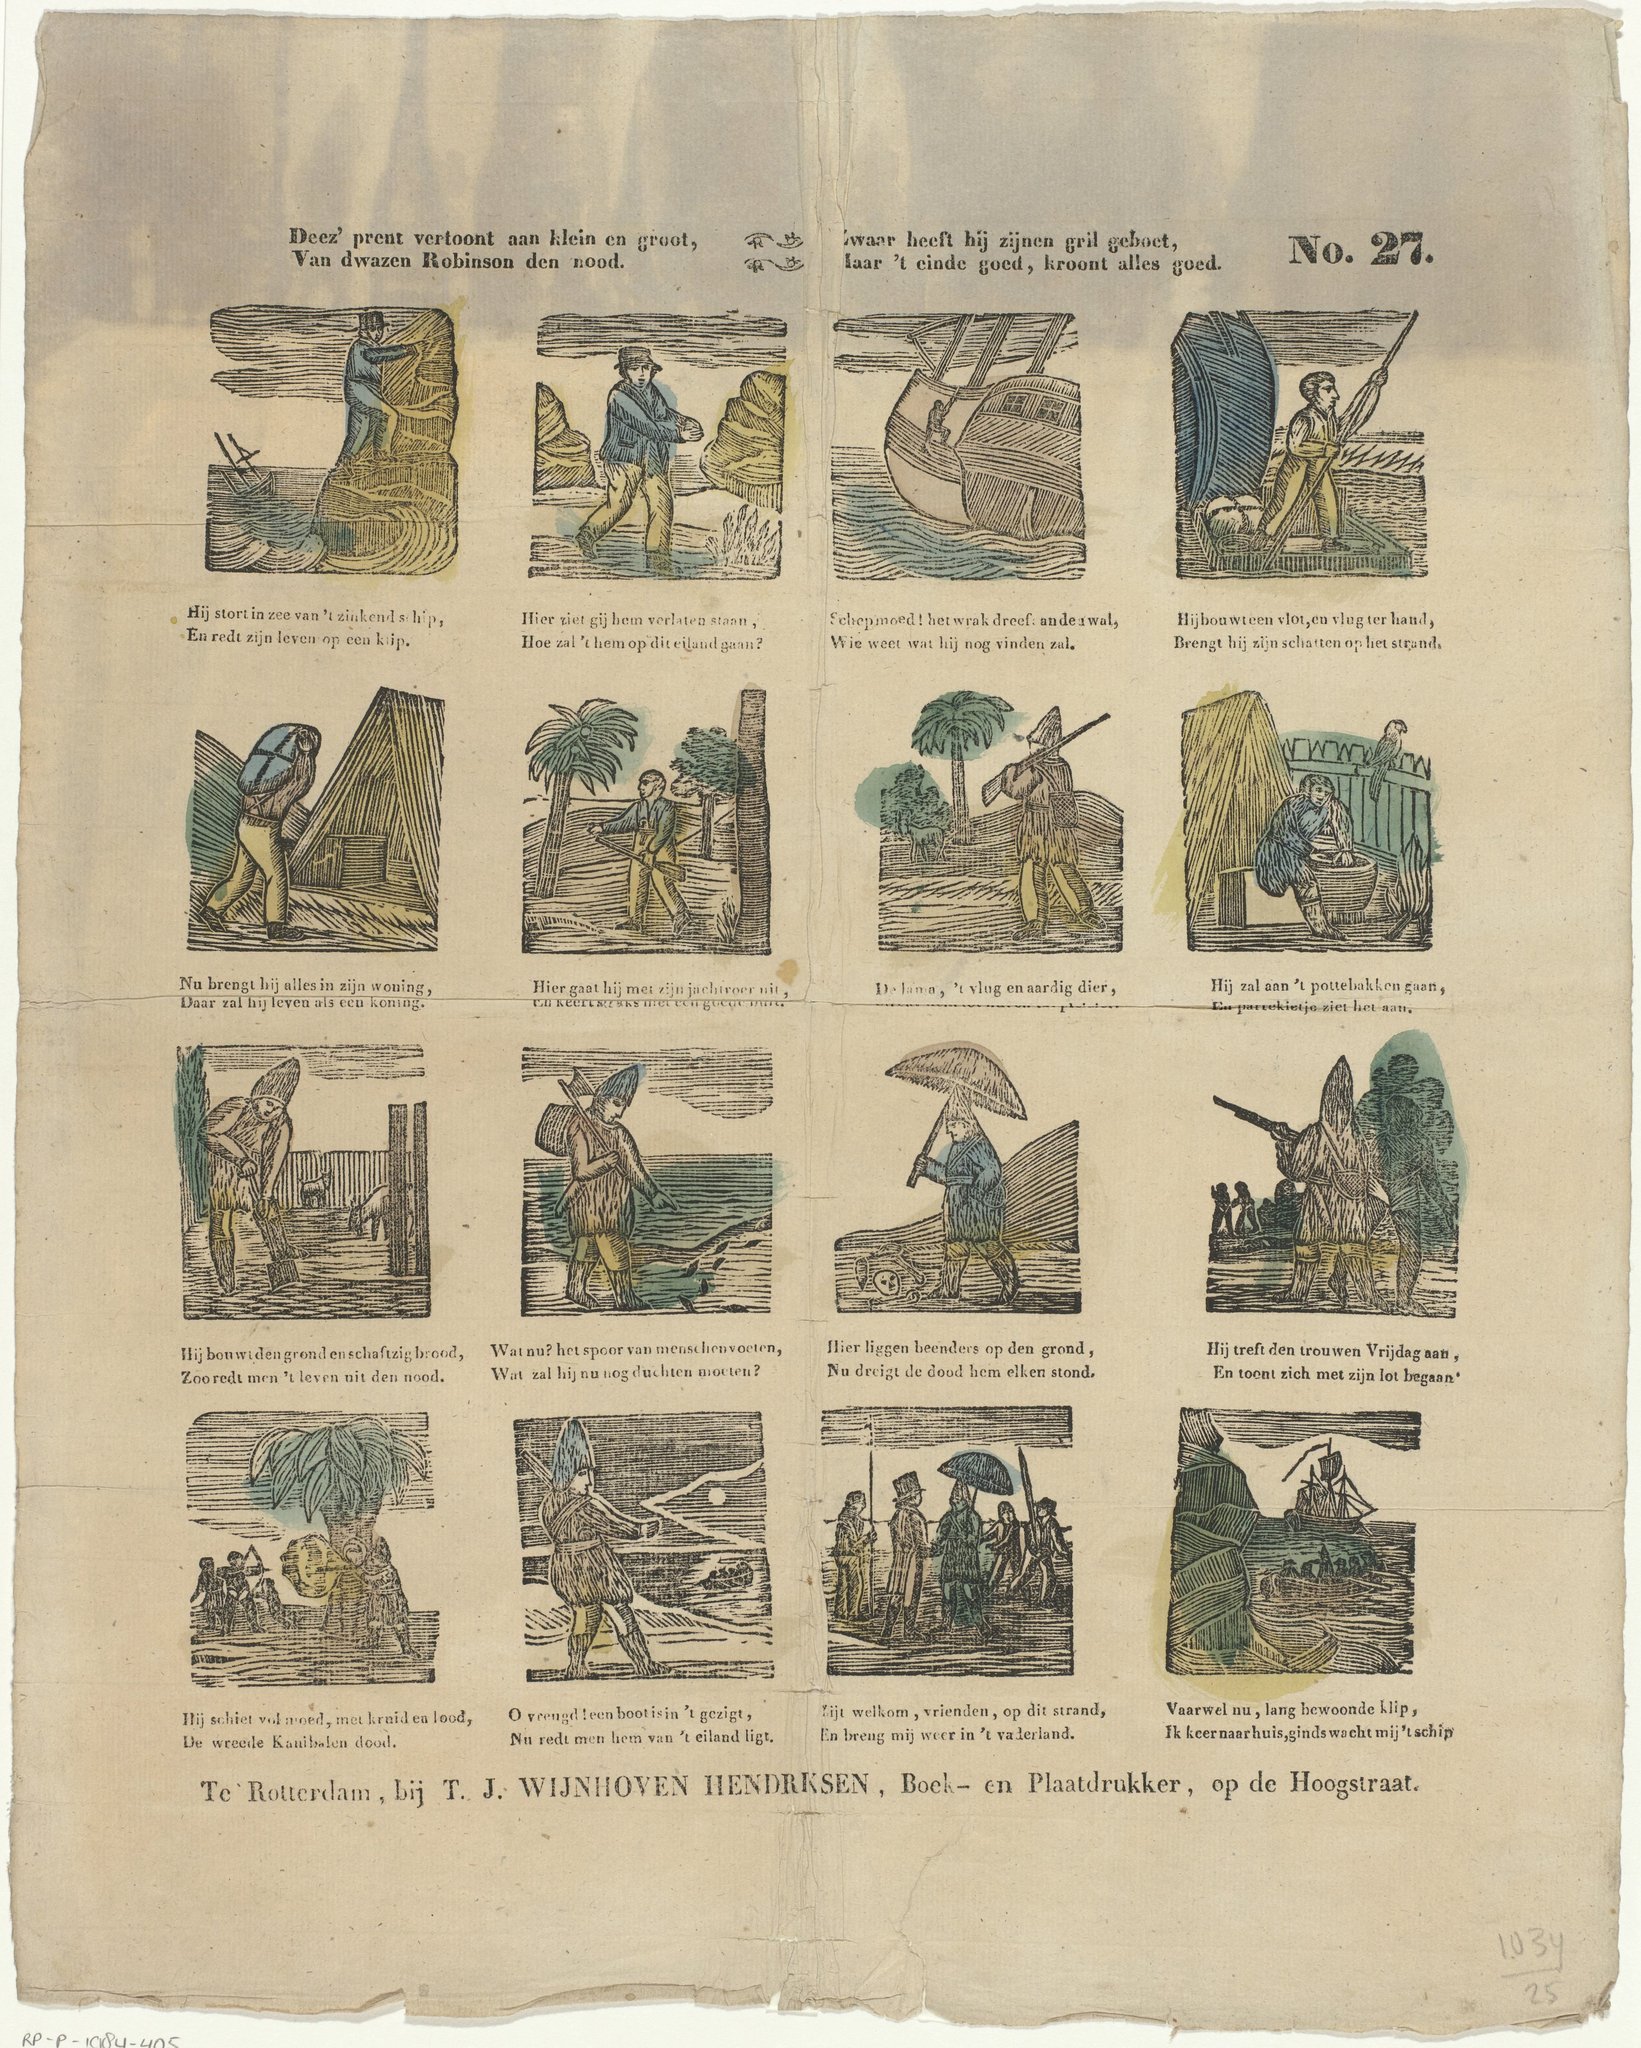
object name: print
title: Deez' prent vertoont aan klein en groot, / Van dwazen Robinson den nood / Zwaar heeft zijnen gril geboet, / Maar 't einde goed, kroont alles goed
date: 1832-1850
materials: paper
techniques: colour, letterpress printing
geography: rotterdam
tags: (scenes from) specific works of literature: defoe, robinson crusoe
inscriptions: collector's mark: Lugt 2760, collector's mark: Lugt 2228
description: Blad met 16 voorstellingen uit het verhaal van Robinson Crusoe die strandt op een eiland. Onder elke afbeelding een tweeregelig vers. Genummerd rechtsboven: No. 27.